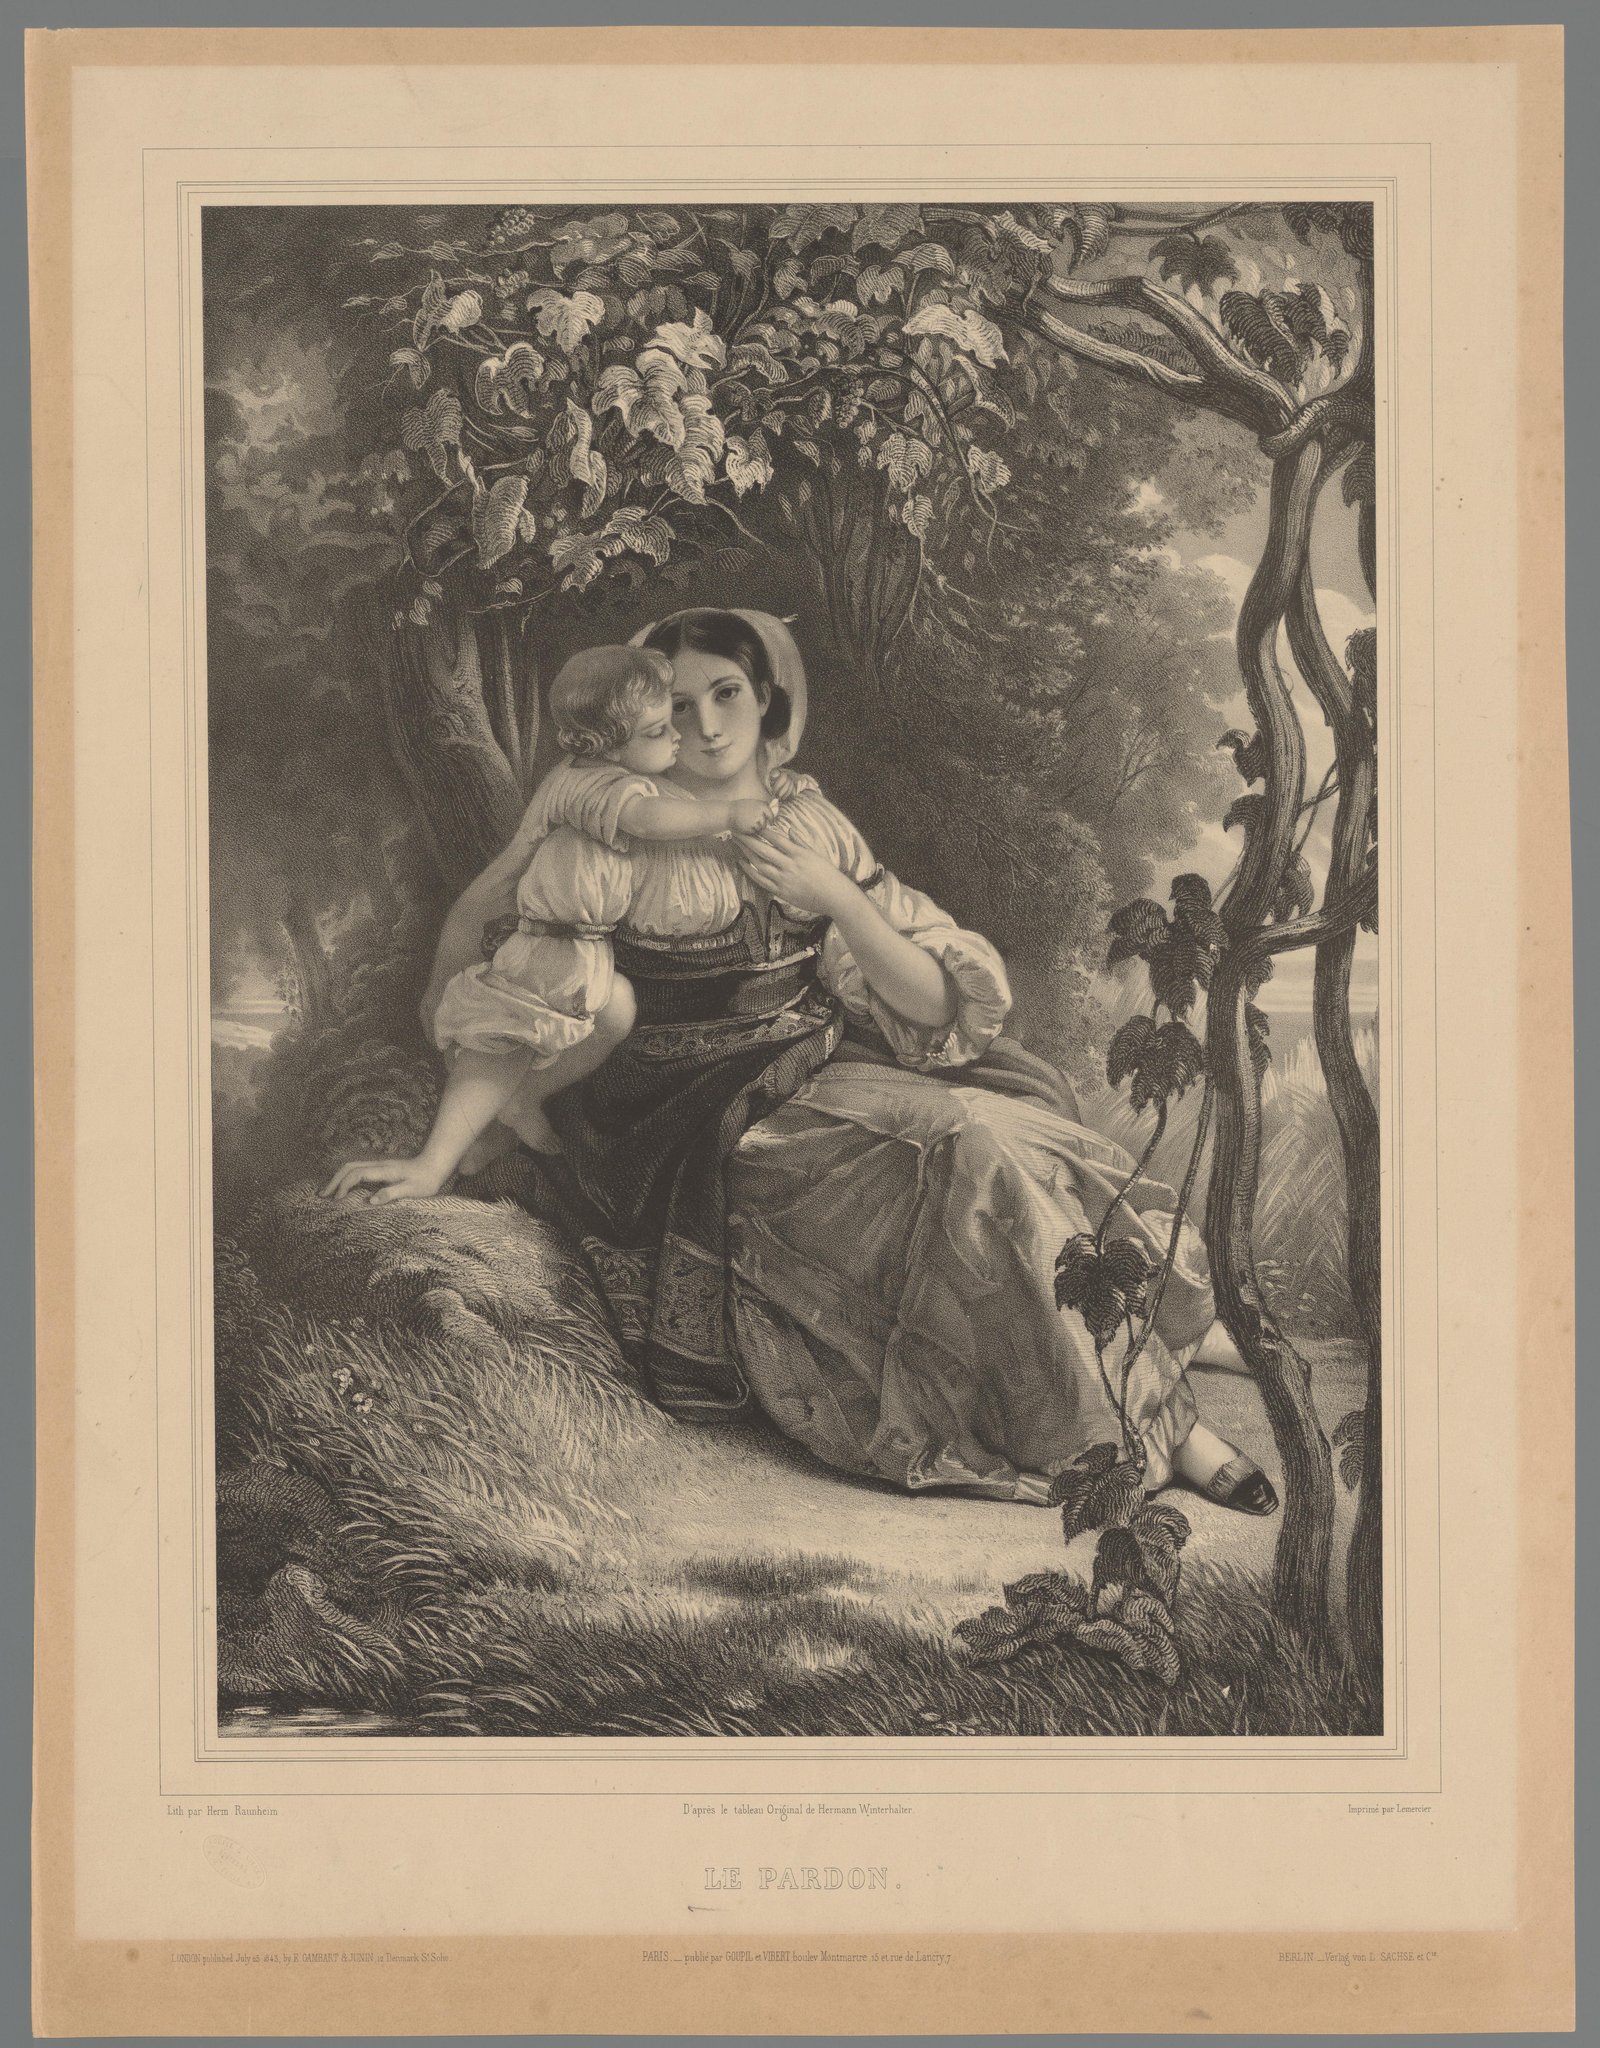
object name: print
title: Moeder met kind in een landschap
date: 1827-1895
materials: paper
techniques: lithograph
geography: paris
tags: forest, wood, mother and baby or young child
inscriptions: collector's mark: Lugt 2228, check stamp: Lugt 5003